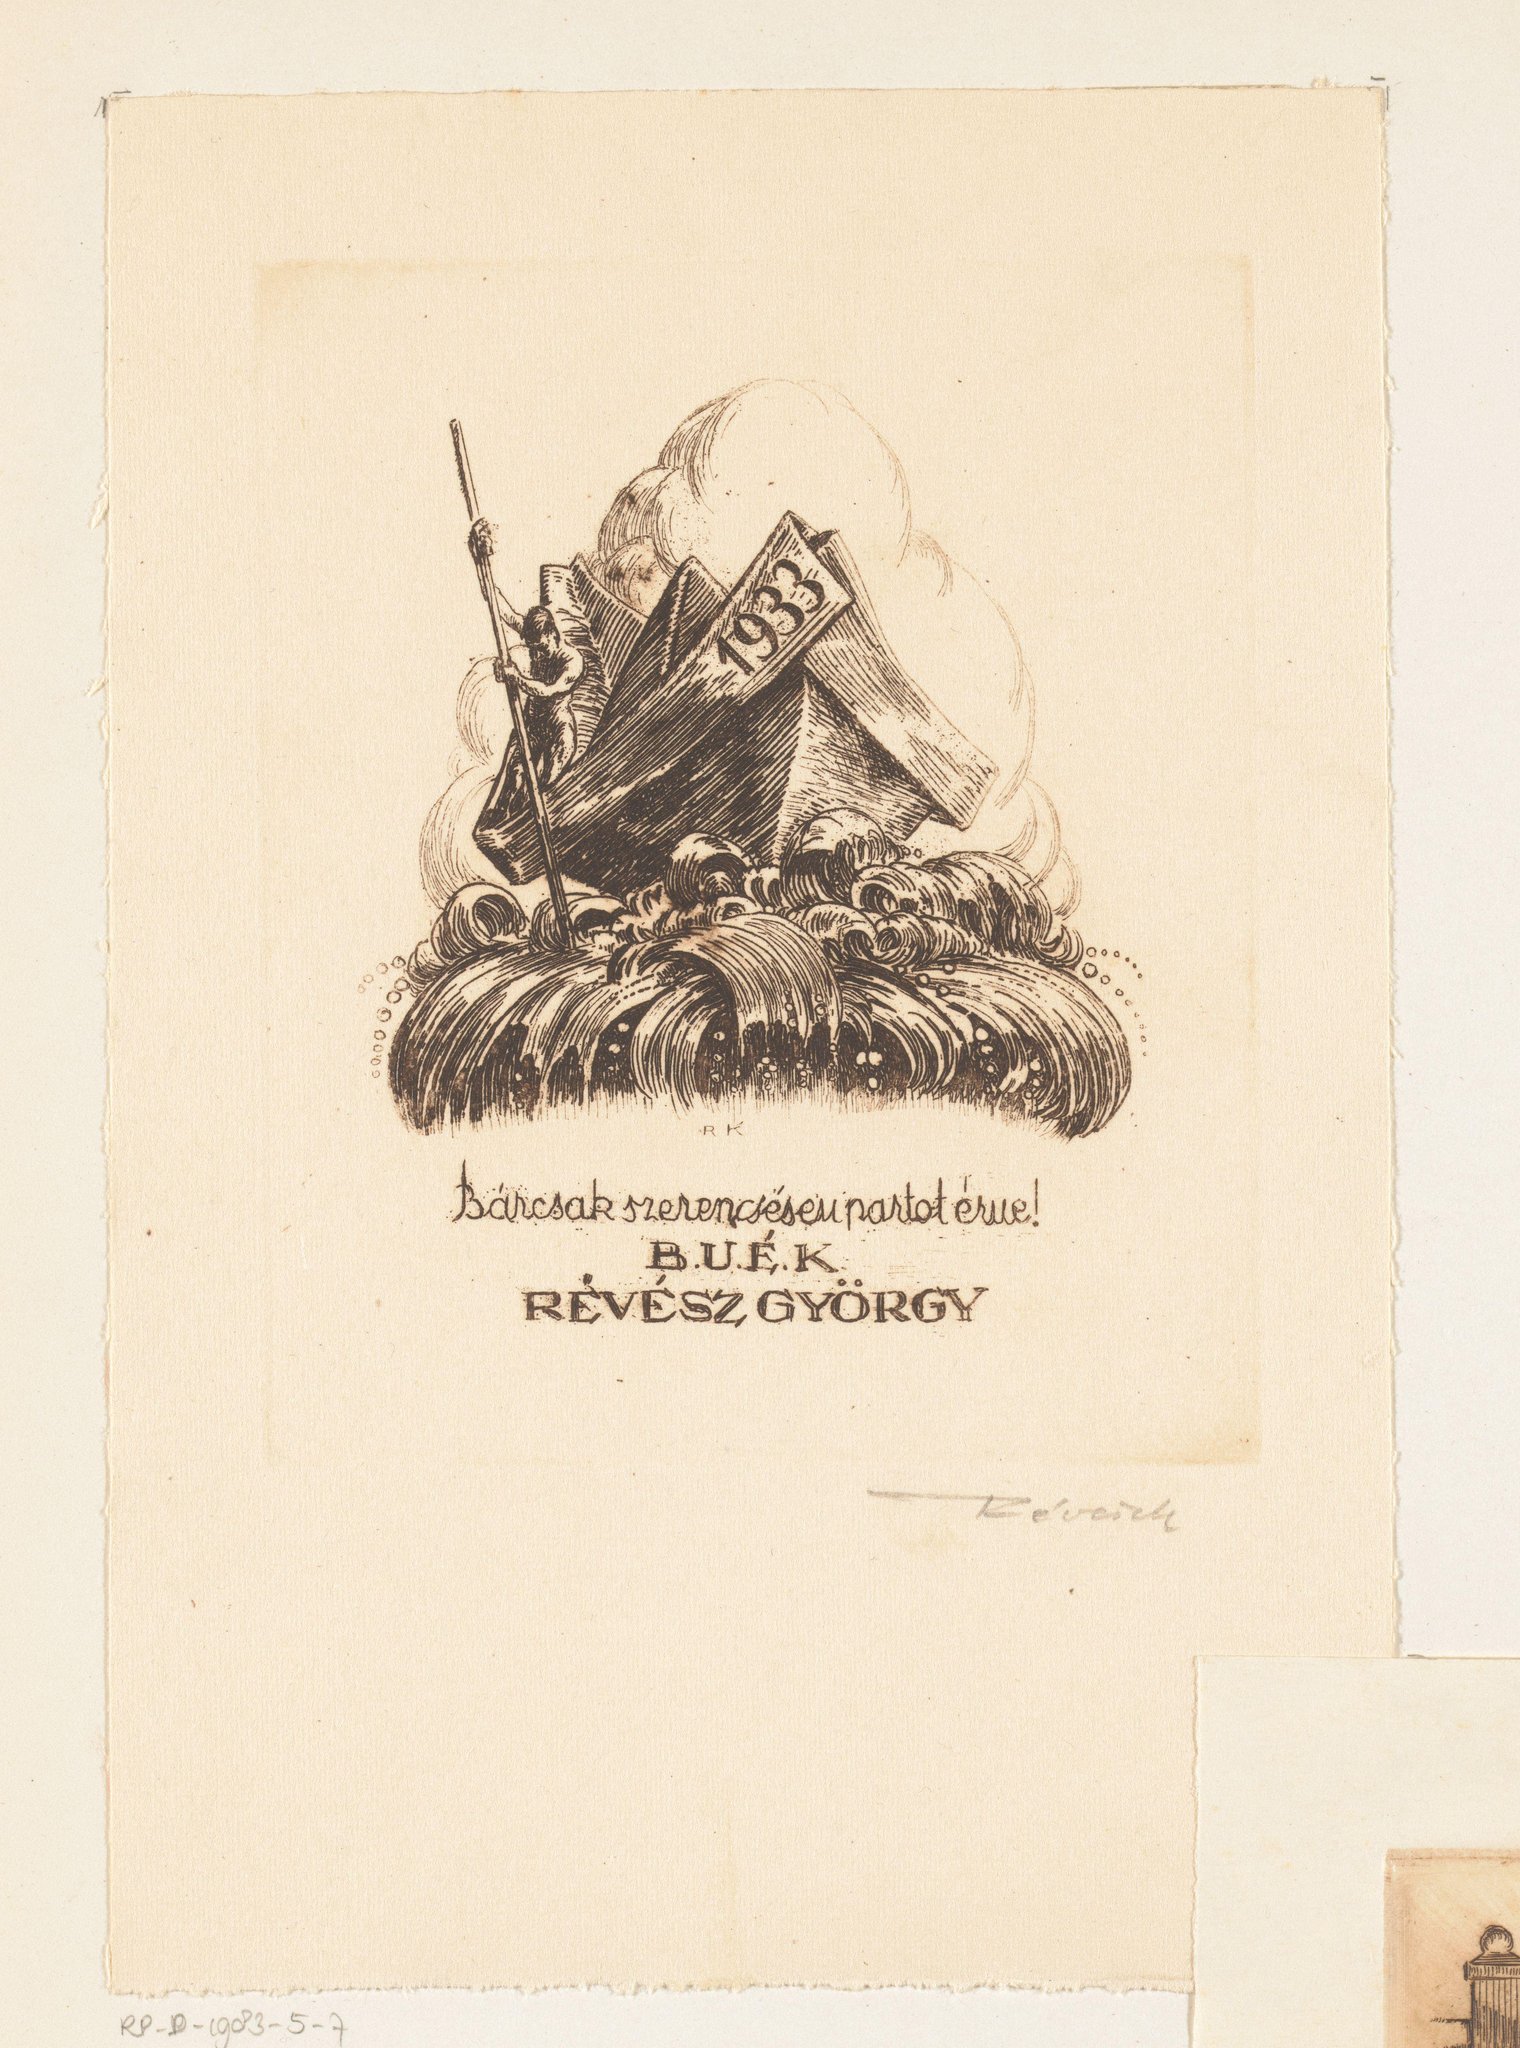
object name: new year card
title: B.U.É.K. Révész György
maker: kornél révész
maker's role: print maker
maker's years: 1885-1944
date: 1932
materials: paper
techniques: etching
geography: budapest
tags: wave, rowing facing forward, pushing, rowing-boat, canoe, etc.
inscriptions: signature: ‘Révész’, workshop stamp: ‘Fecit/ Révész Kornél/ Budapest’, date: ‘1932’, inscription: ‘Révész = Fährmann’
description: Ex libris maakt deel uit van omslag met 64 ex libris op 34 losse opzetvellen, een catalogus en een tekstblad.